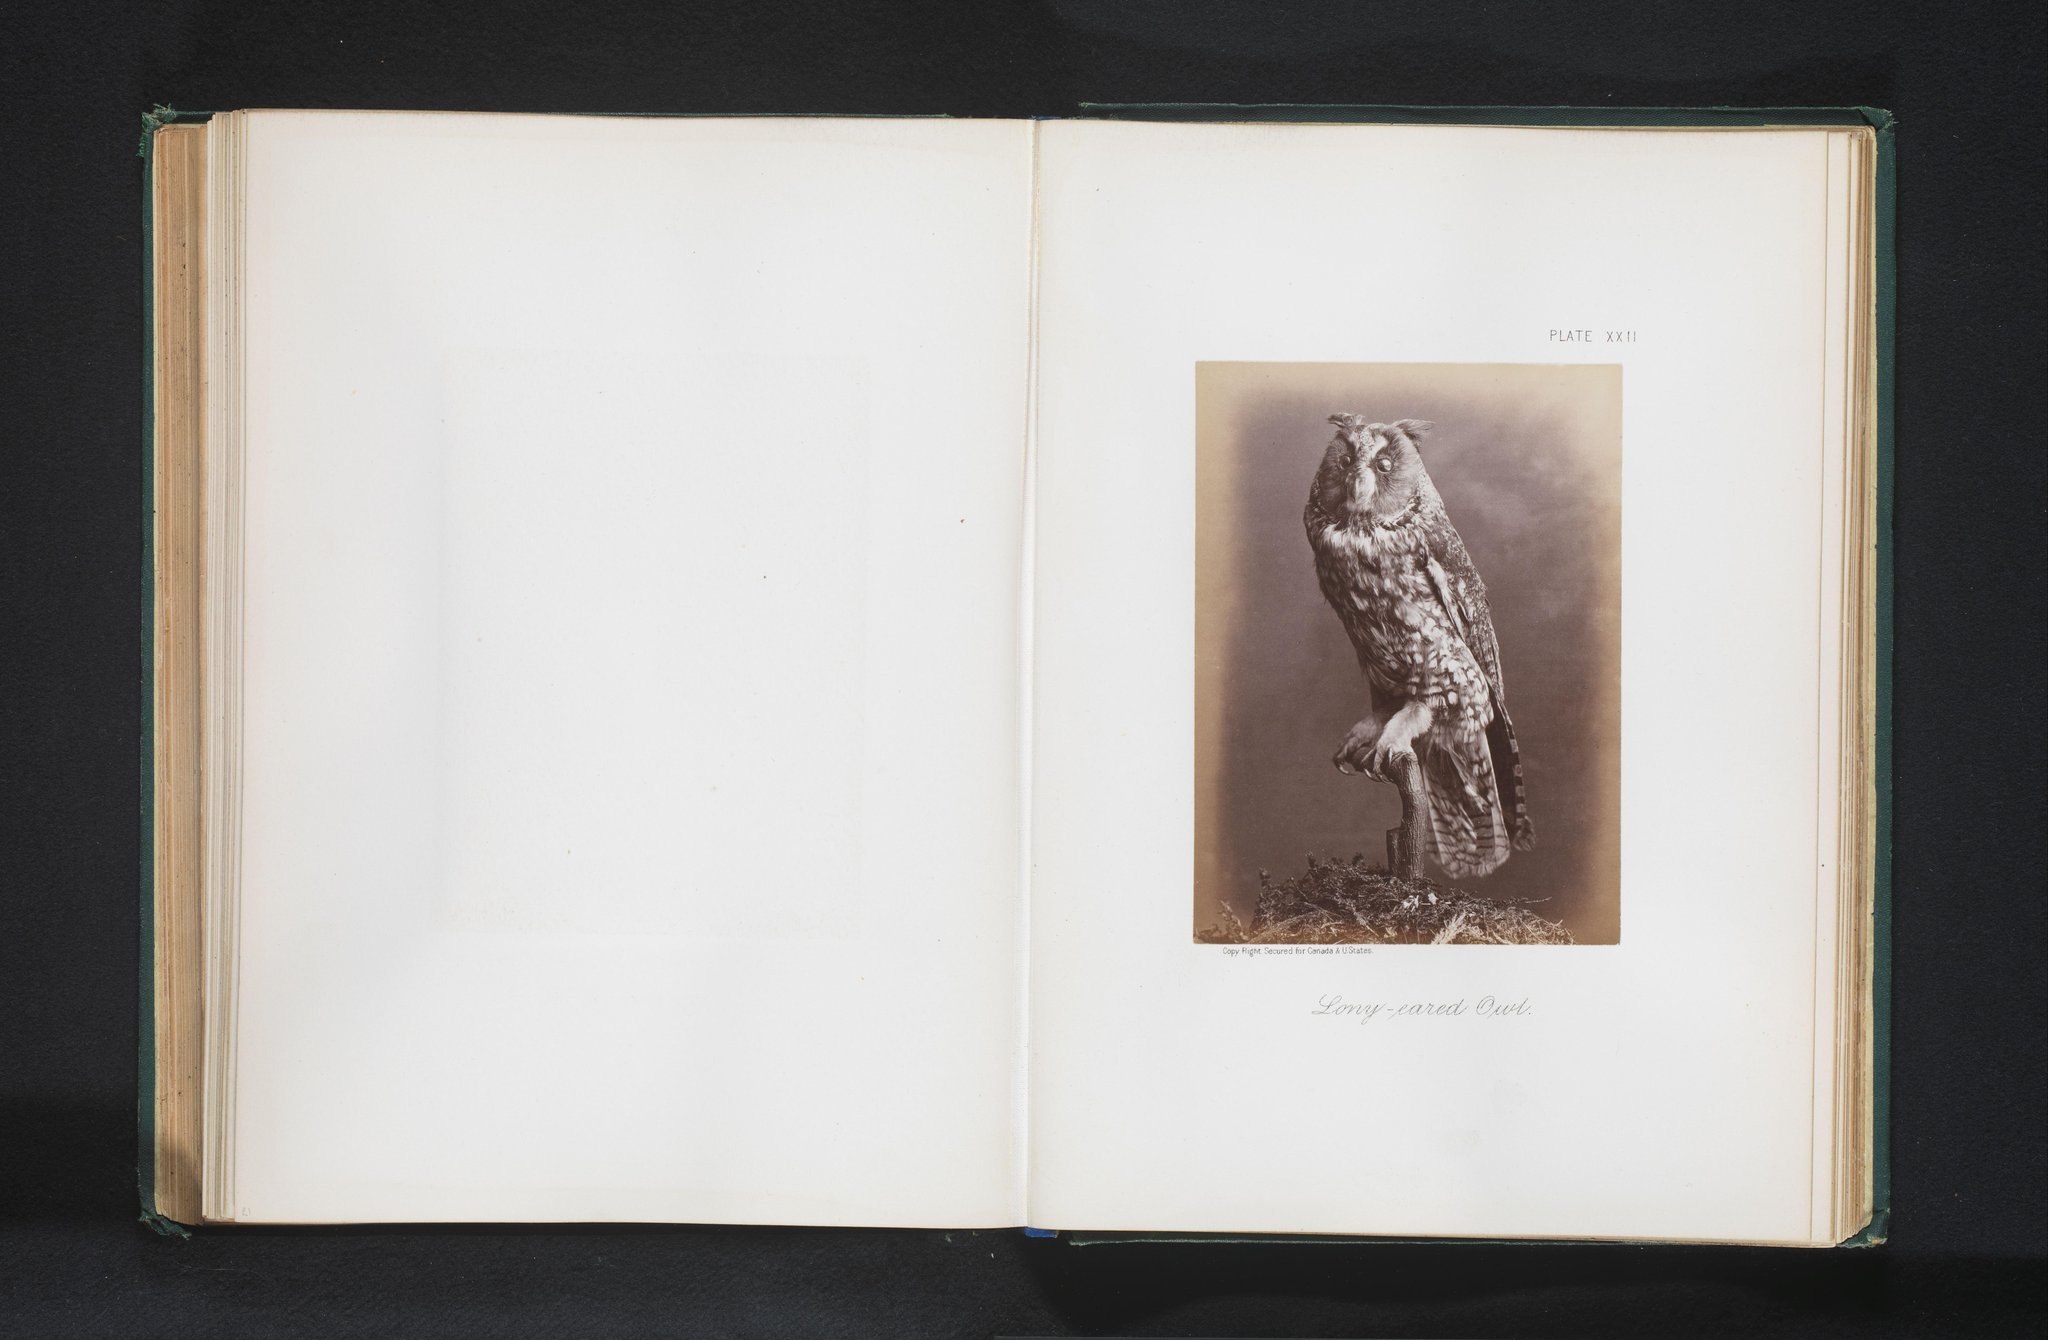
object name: photograph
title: Opgezette ransuil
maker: william notman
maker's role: fotograaf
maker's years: 1826-1891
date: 1871-1876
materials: paper, photographic support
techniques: albumen print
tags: collection of animals, owls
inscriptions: inscription: ‘Copy Right Secured for Canada & U.States’, number: ‘PLATE XXII’